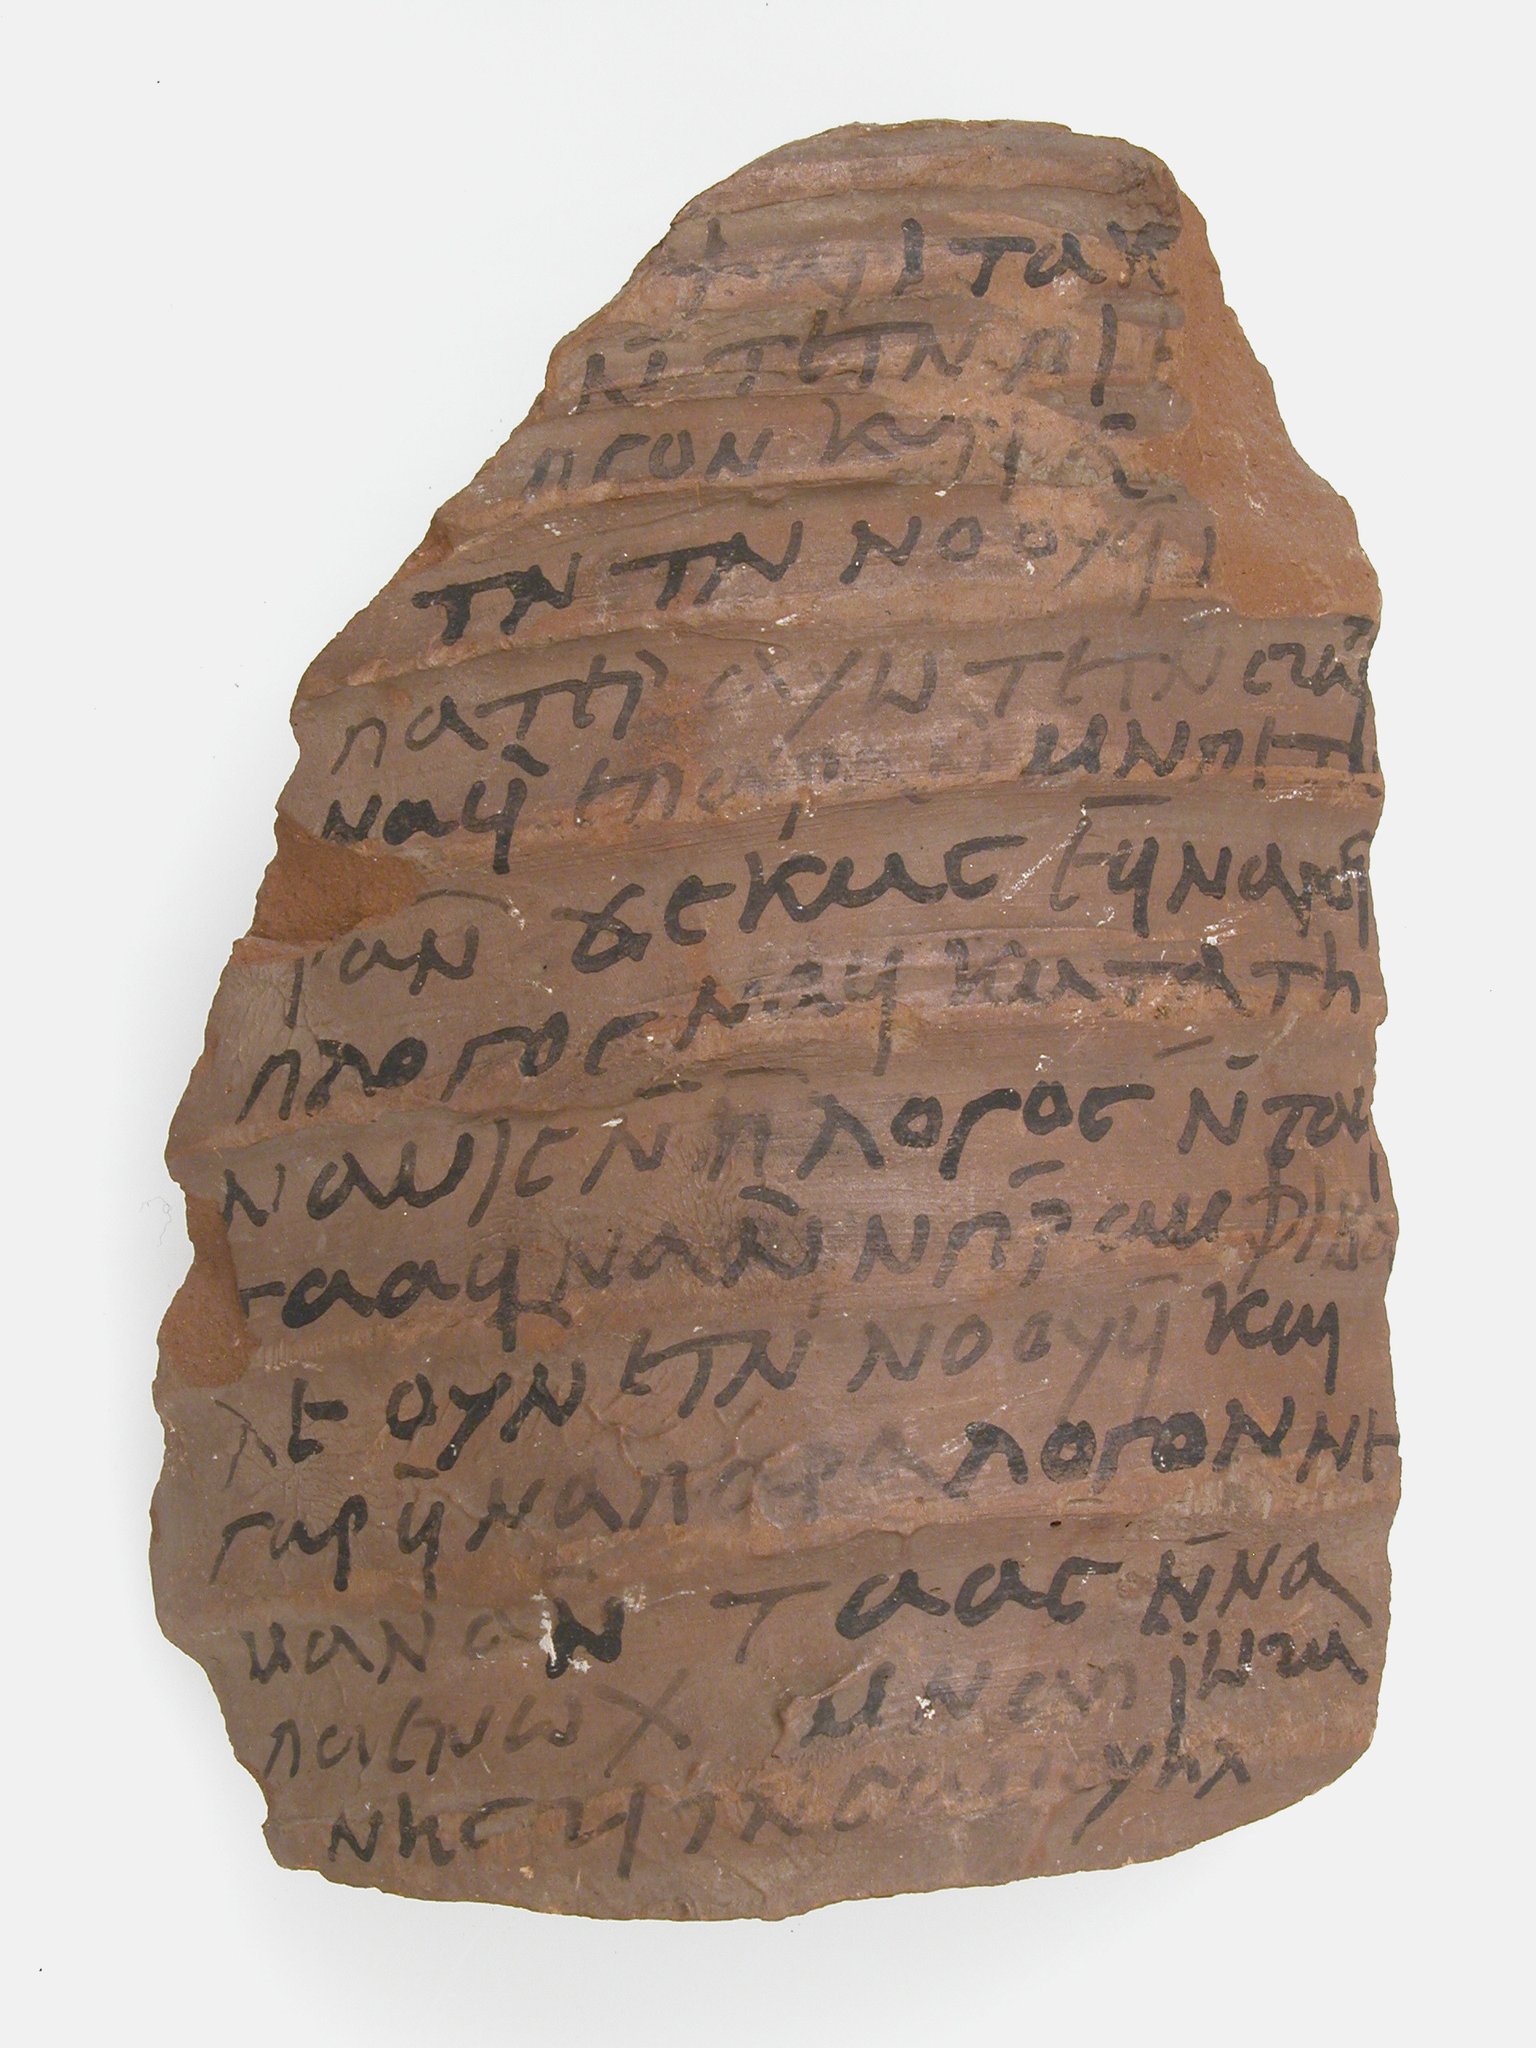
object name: ostrakon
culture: coptic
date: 601-700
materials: ink, pottery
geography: egypt